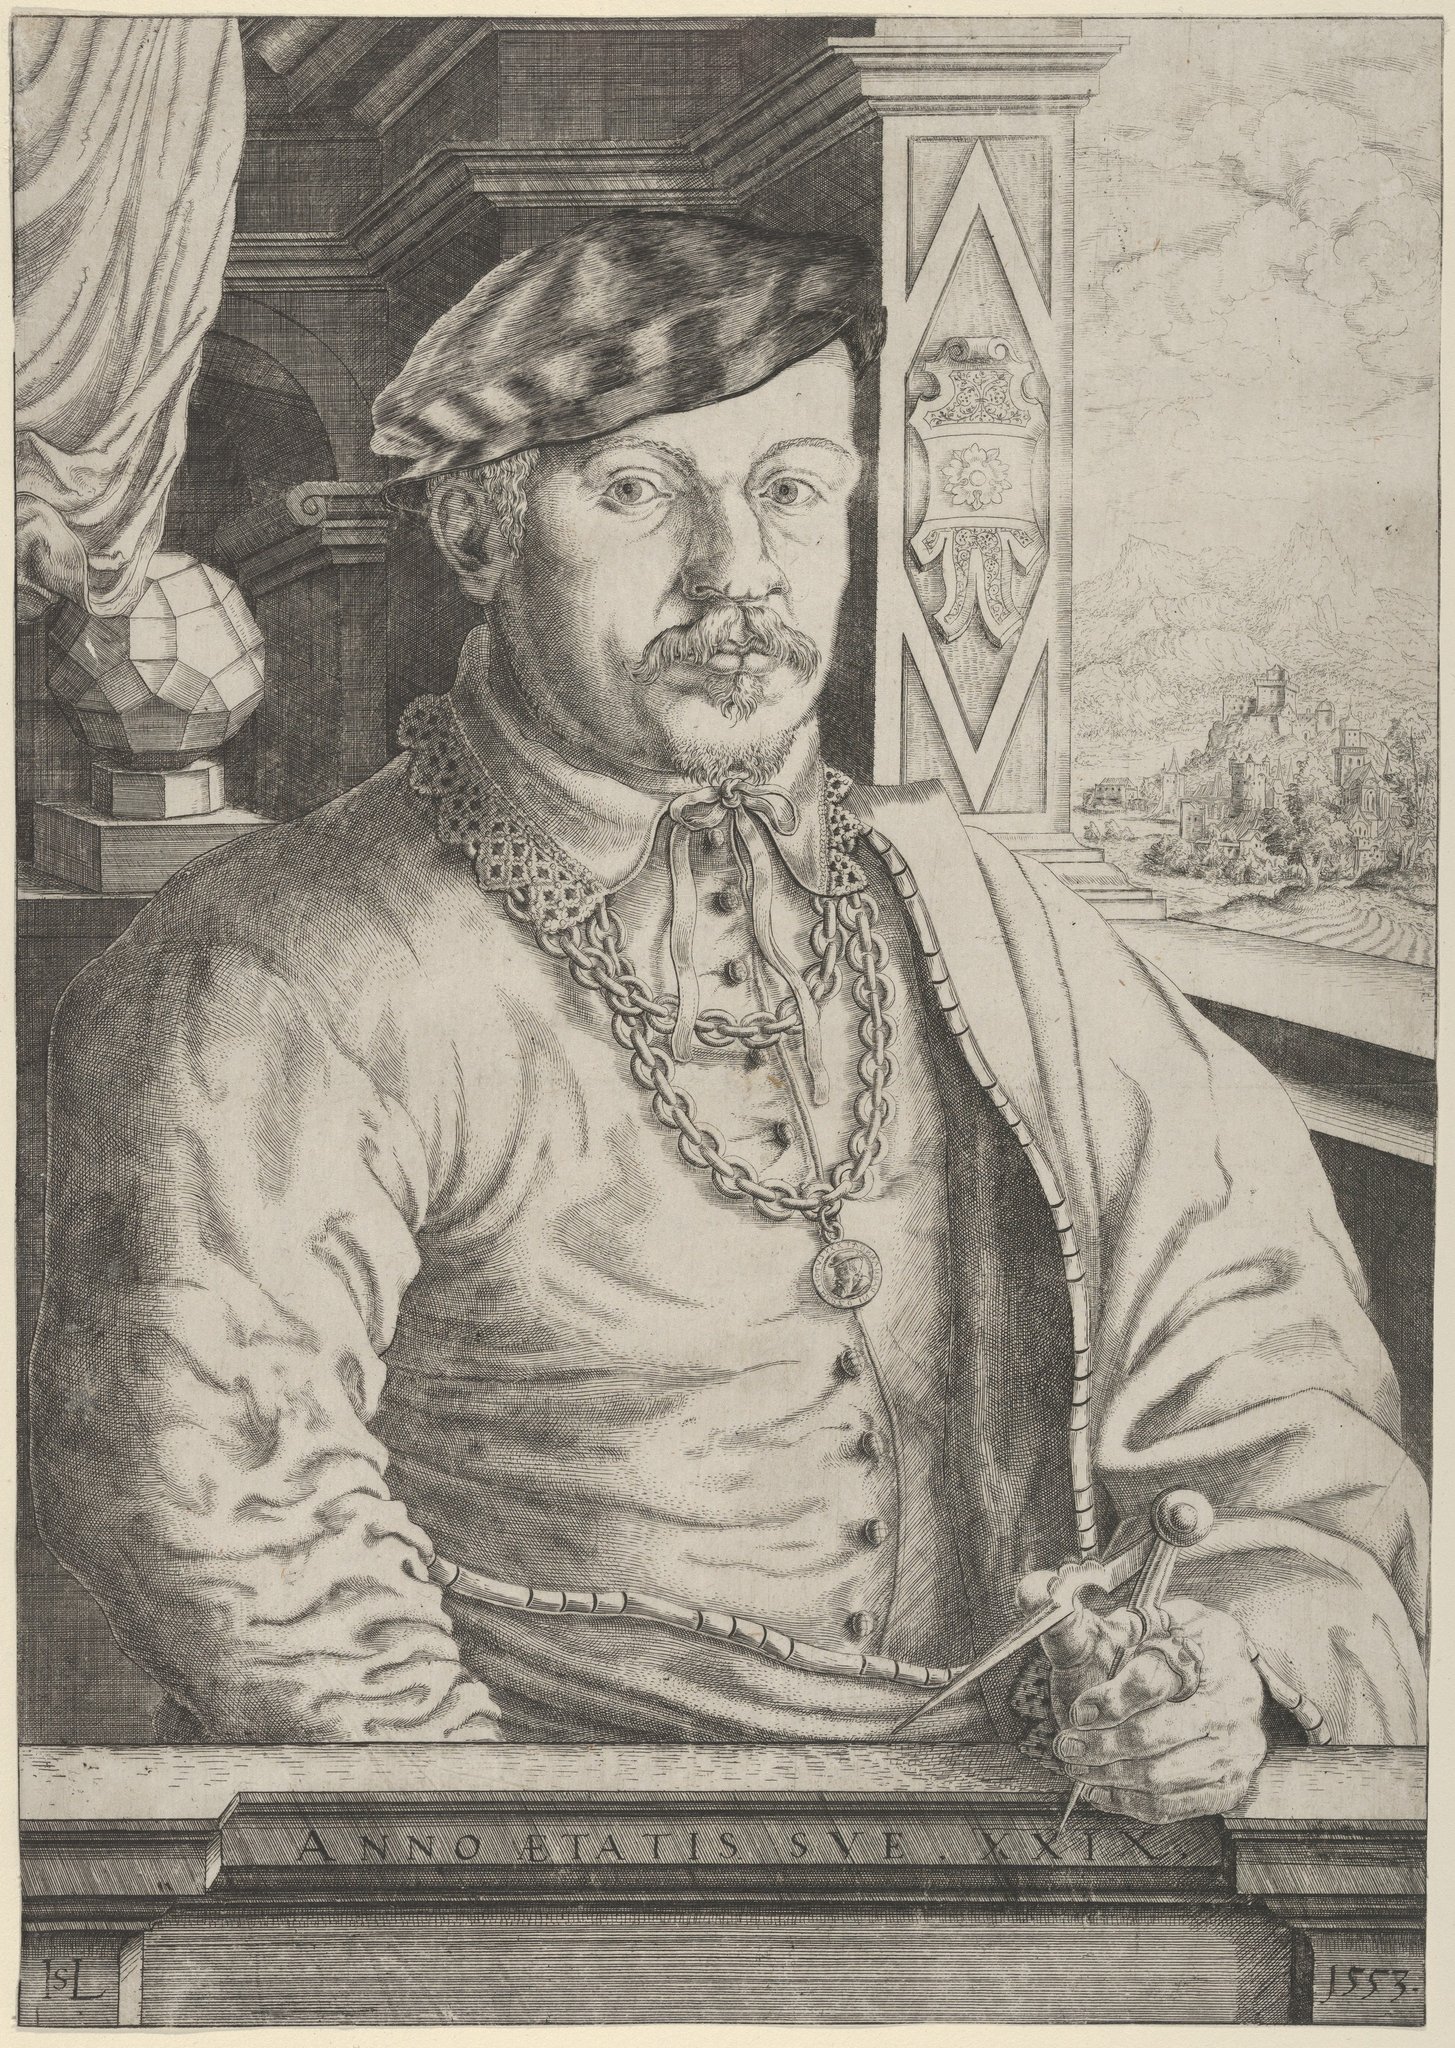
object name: print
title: Oswald von Eck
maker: hanns lautensack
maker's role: artist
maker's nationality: german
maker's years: 1515-1566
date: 1553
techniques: etching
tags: men,portraits,compass